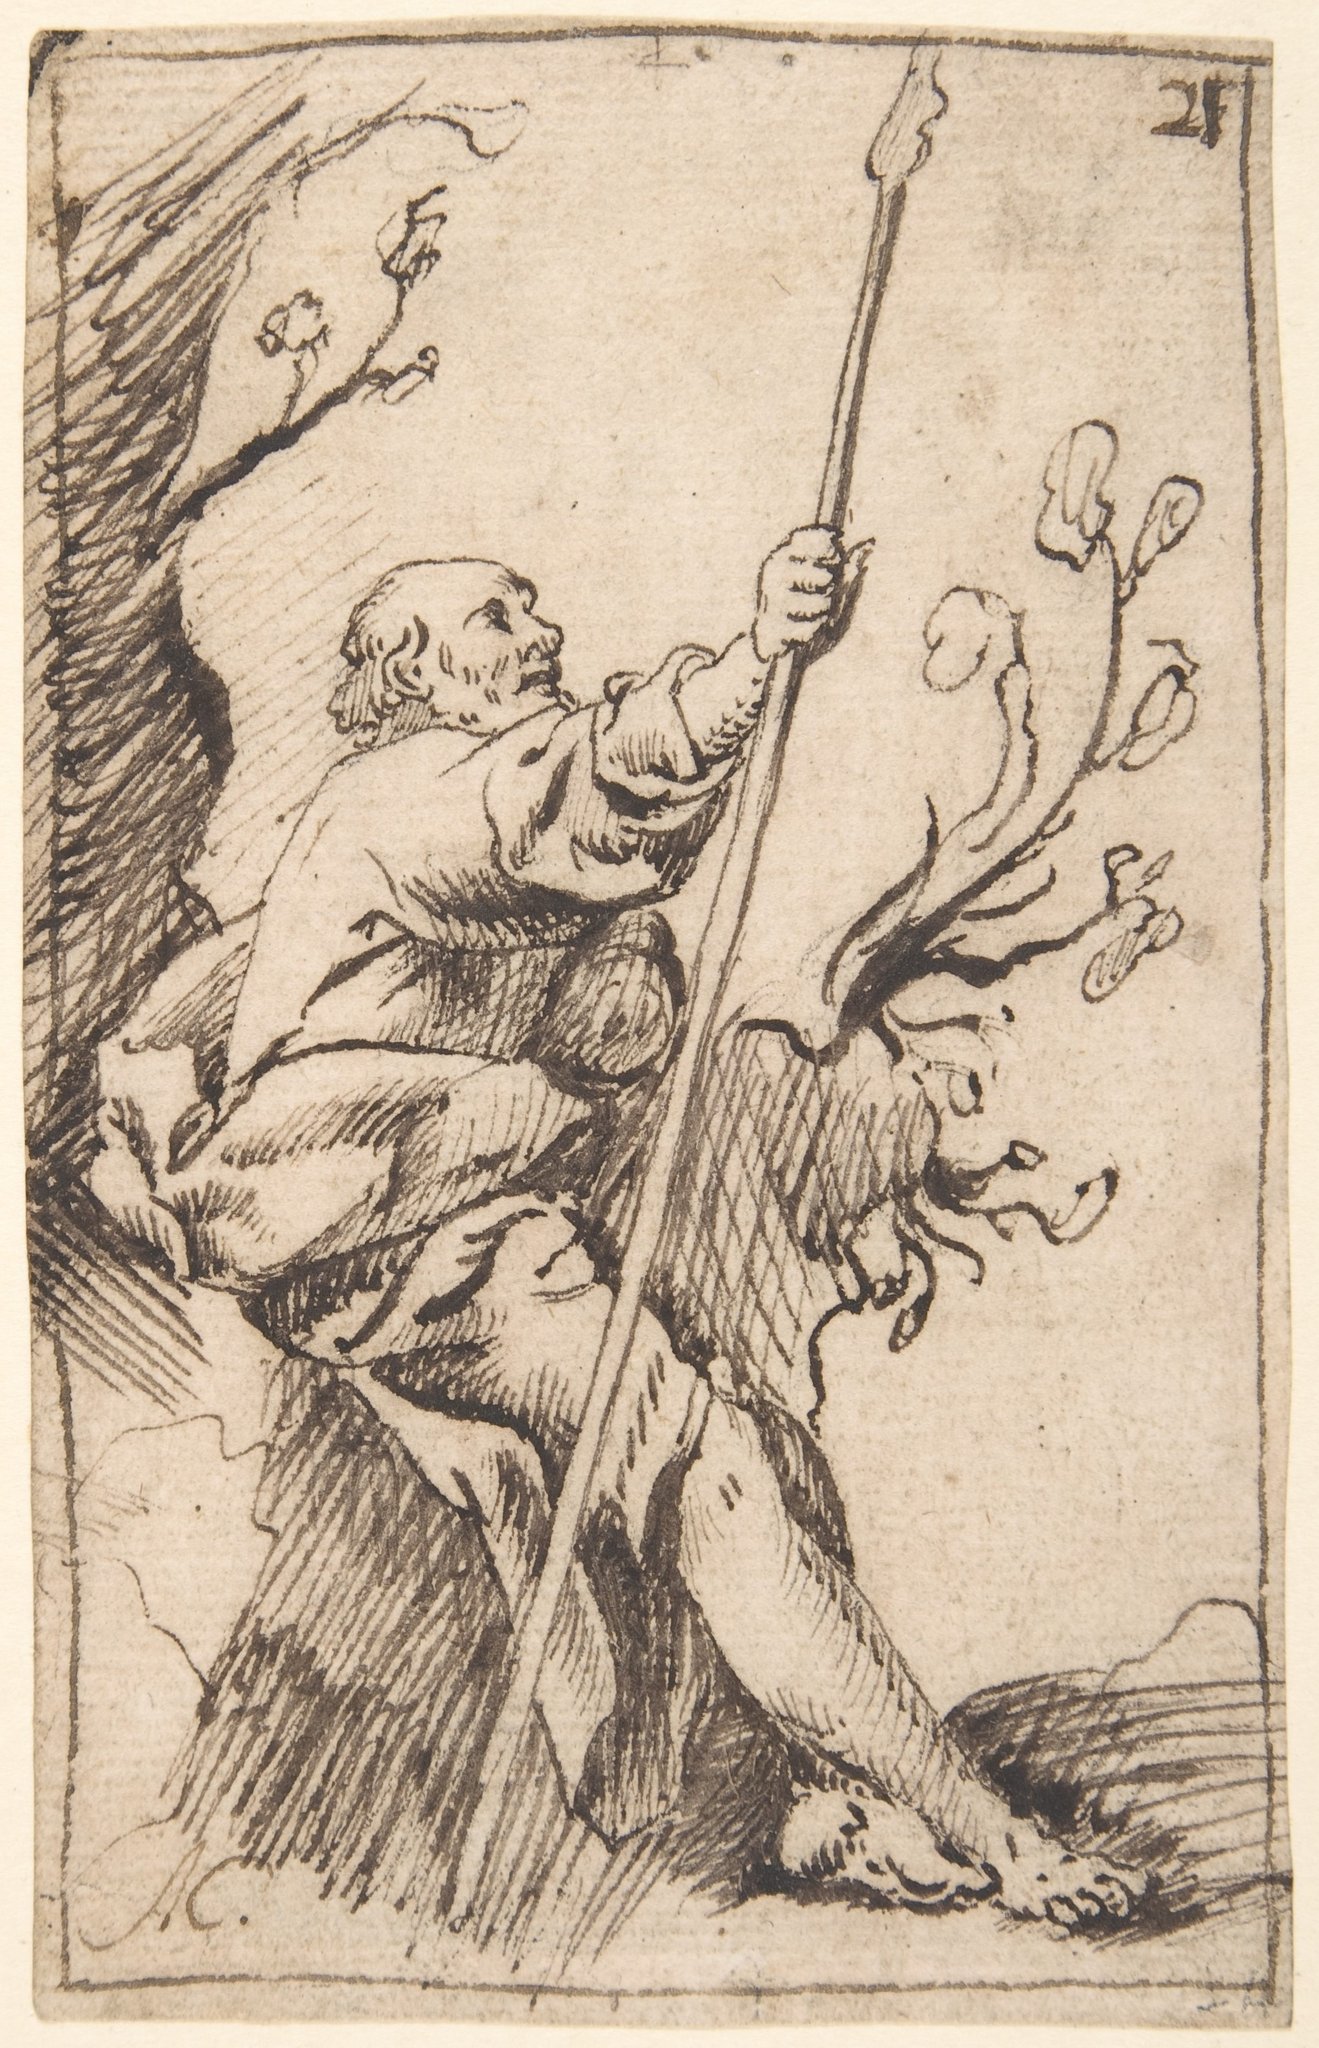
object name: drawing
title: Figure of St. James the Great Seated in a Landscape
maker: antonio del castillo y saavedra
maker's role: artist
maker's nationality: spanish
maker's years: 1616-1668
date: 1616-1668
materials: chalk, ink, paper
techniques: pen, drawing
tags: landscapes,saints